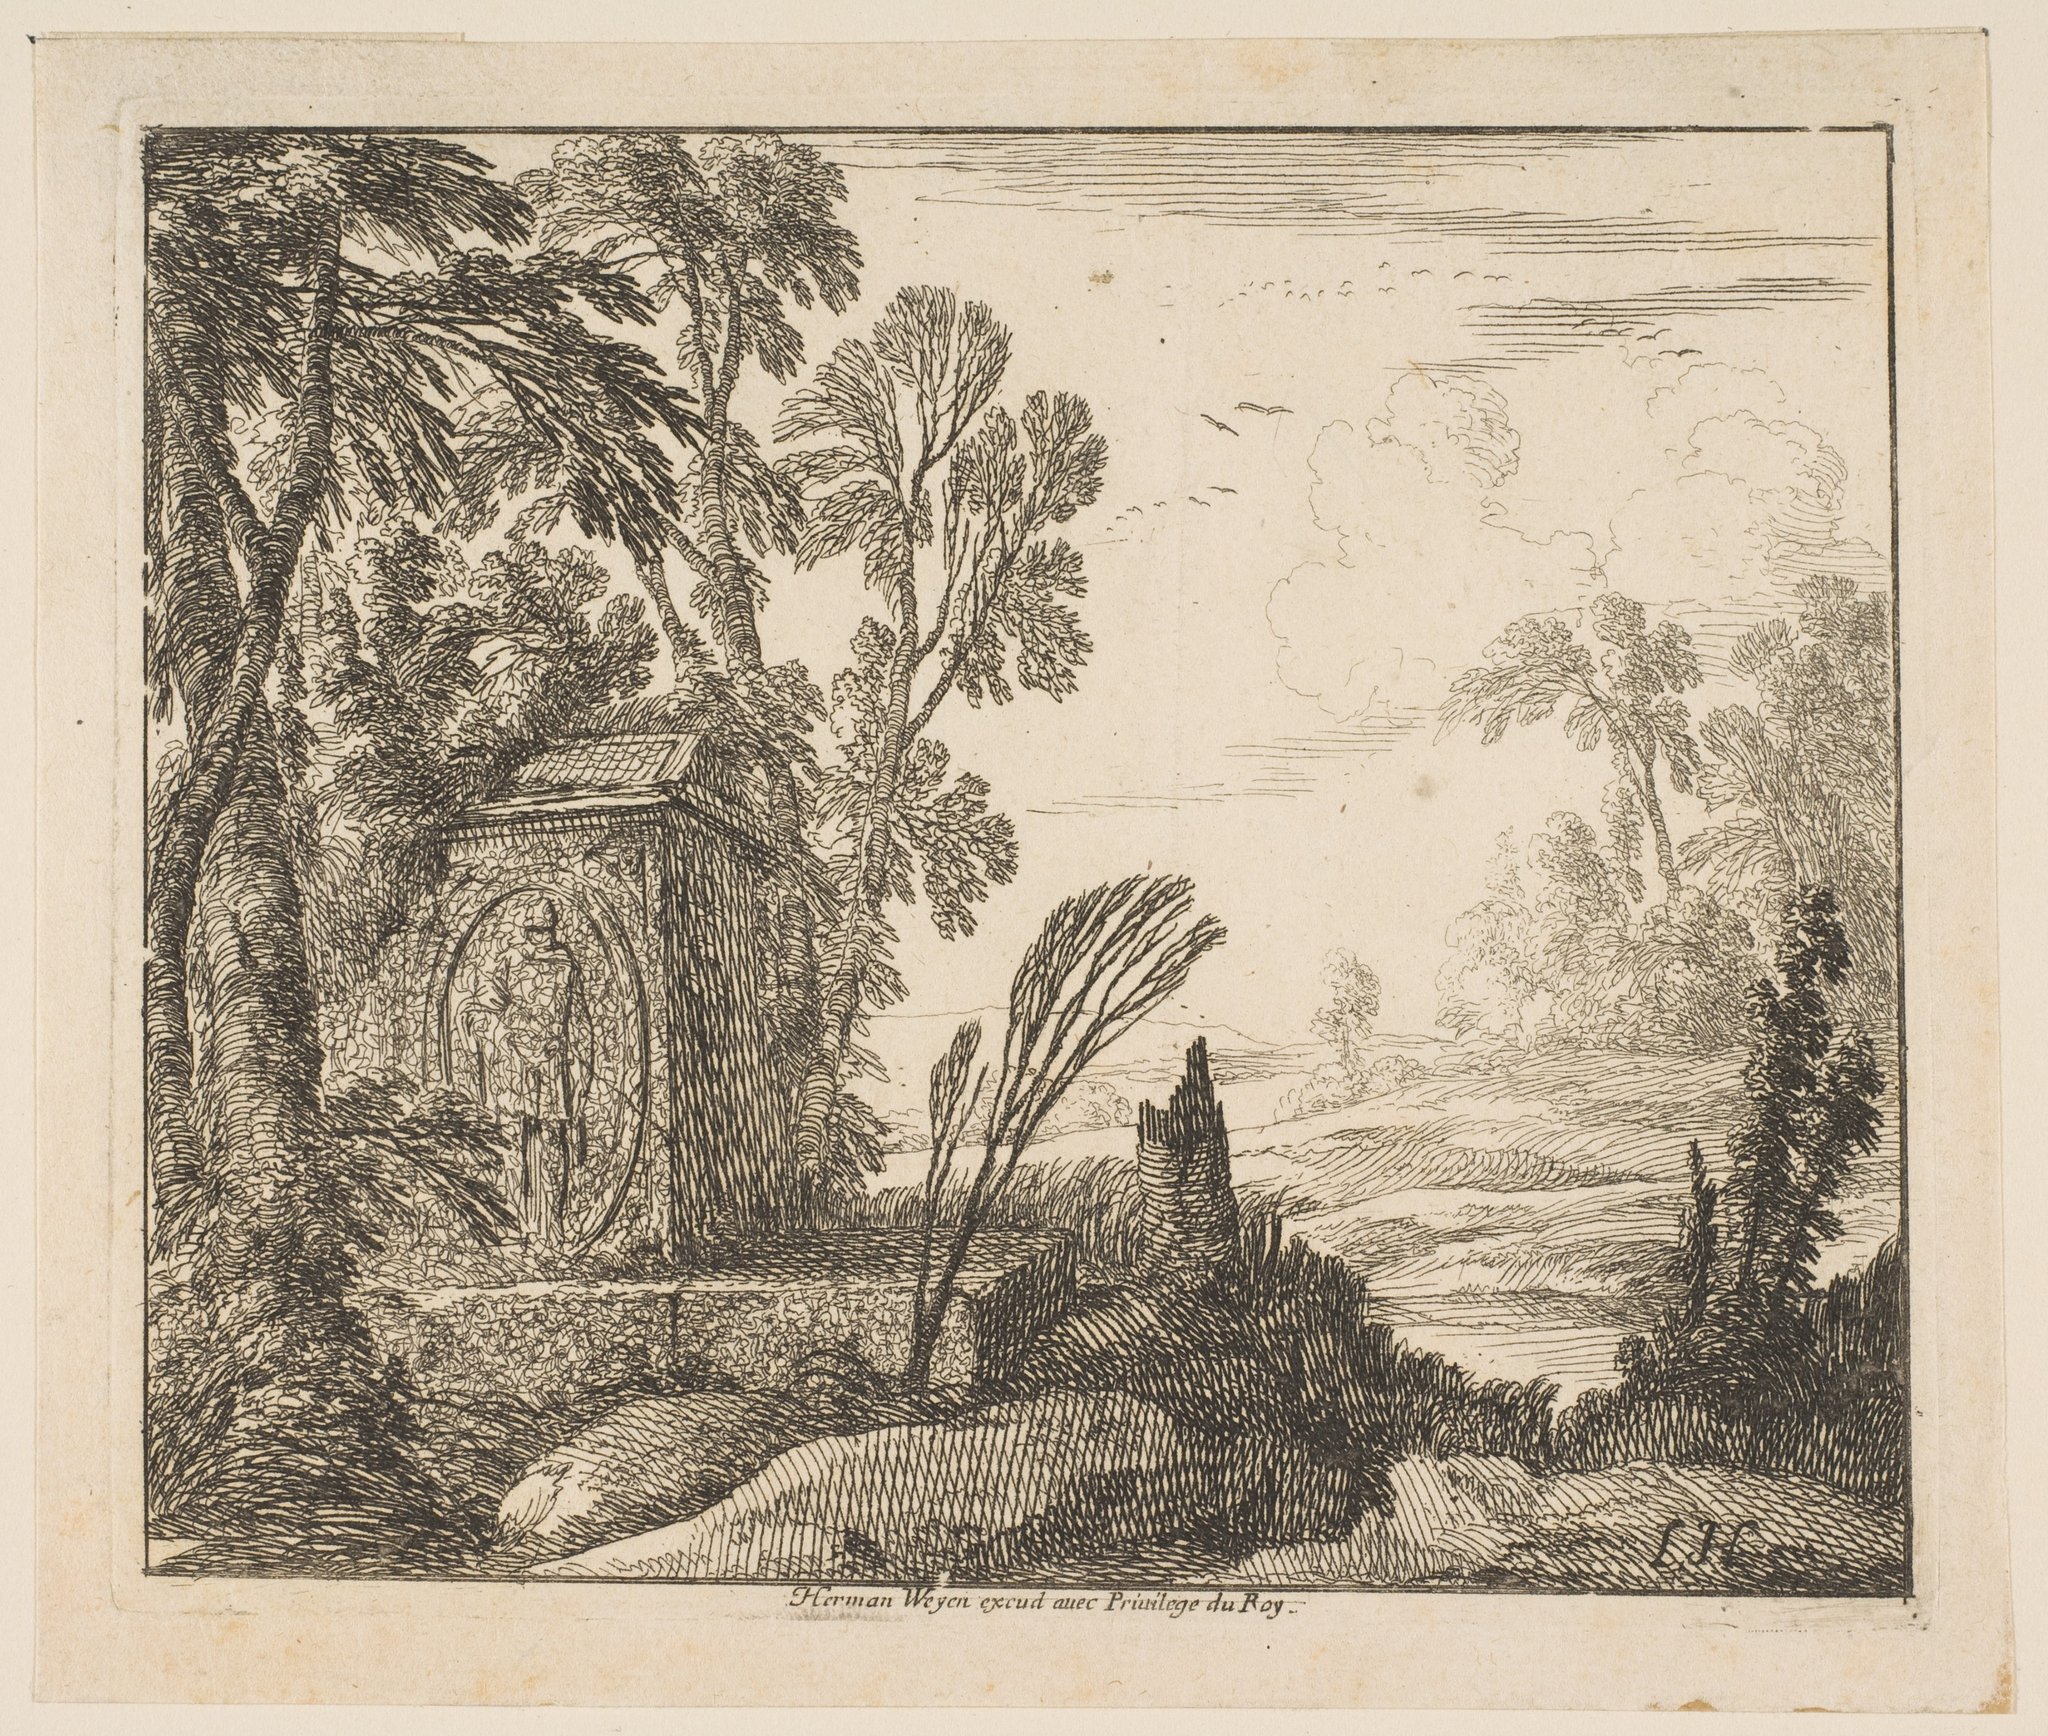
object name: print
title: The Sarcophagus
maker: laurent de la hyre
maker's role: artist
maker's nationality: french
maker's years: 1606-1656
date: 1640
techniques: etching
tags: sarcophagus